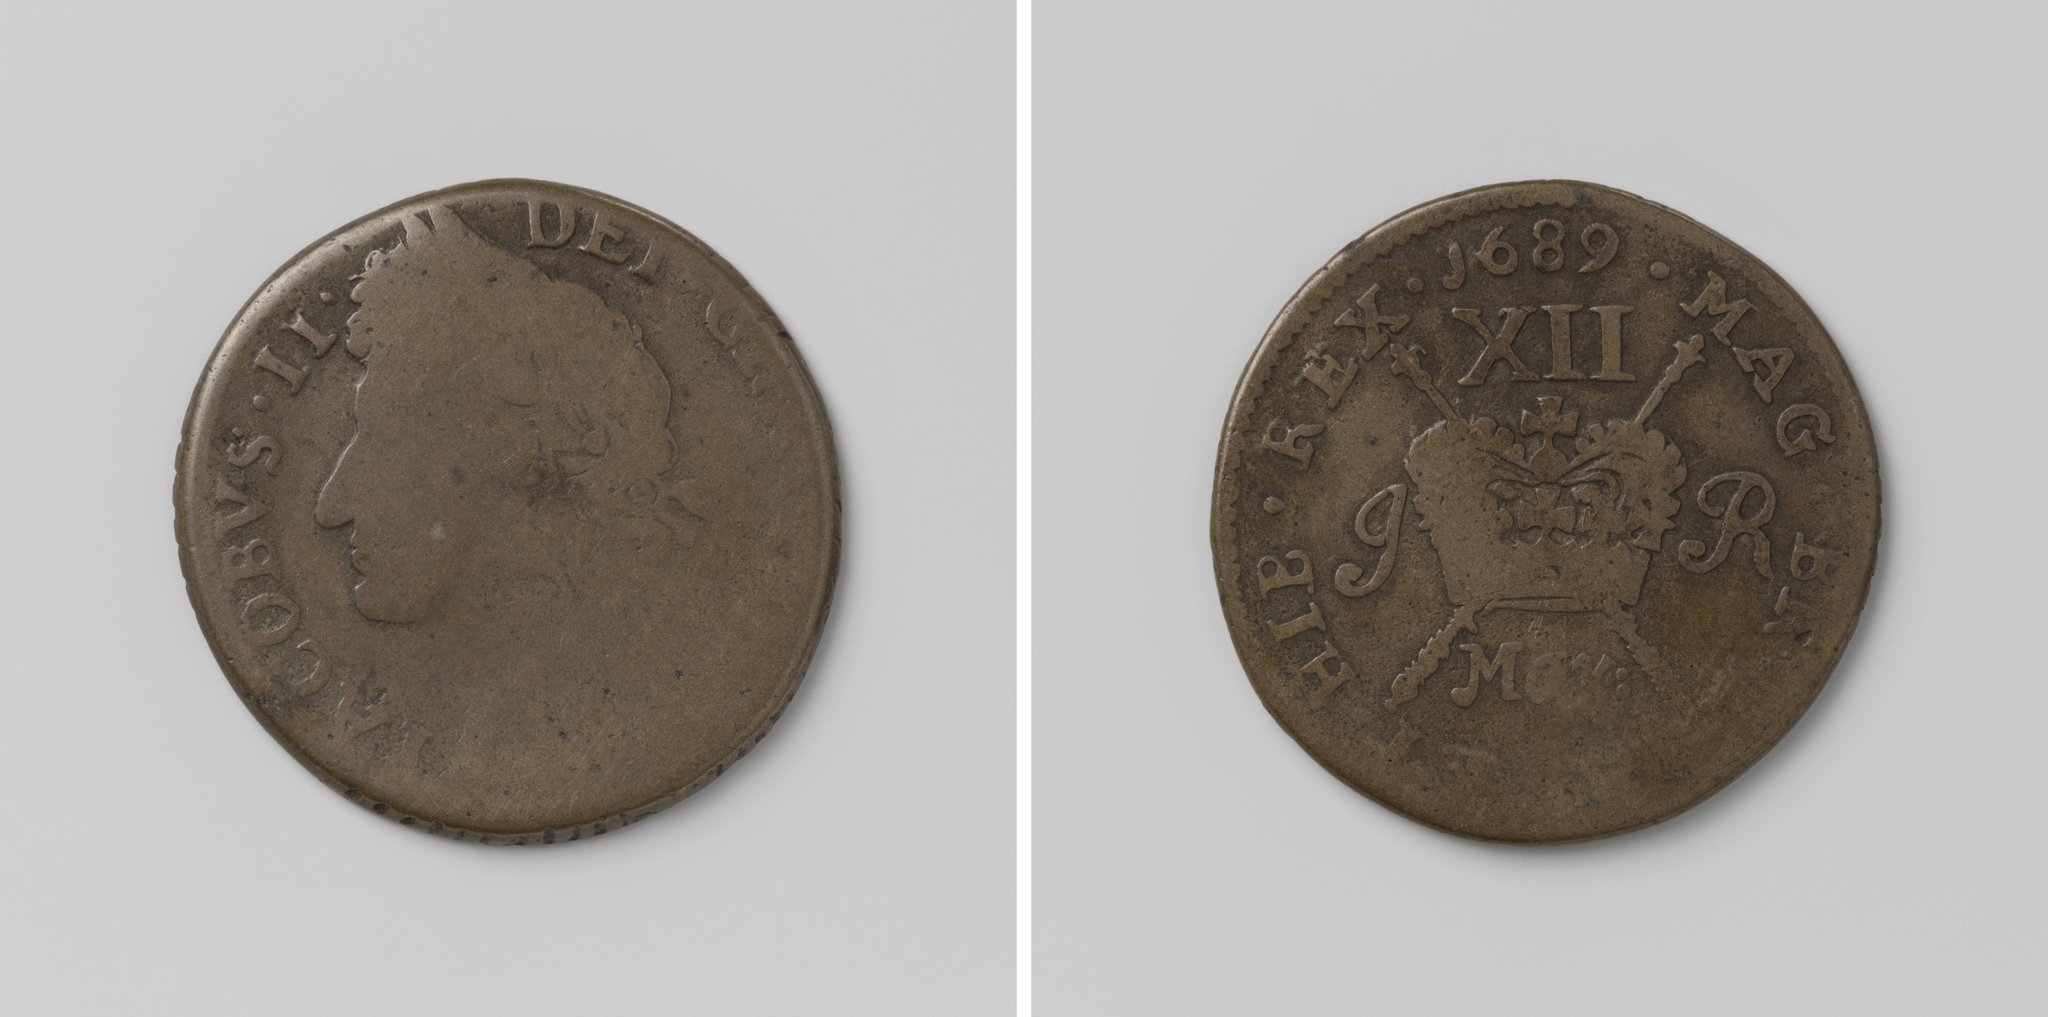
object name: shilling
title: Shilling, noodmunt van Jacobus II, koning van Engeland, uit maart 1689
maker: Anonymous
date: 1603-1689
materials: copper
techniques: striking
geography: ireland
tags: jacobus ii (koning van engeland en schotland)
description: Voorzijde: borststuk man met lauwerkrans binnen omschrift. Keerzijde: kroon, waardoor twee gekruiste scepters steken tussen monogram van letters J en R; boven kroon Romeinse cijfer XXX, onder kroon opschrift "Mar: " binnen omschrift